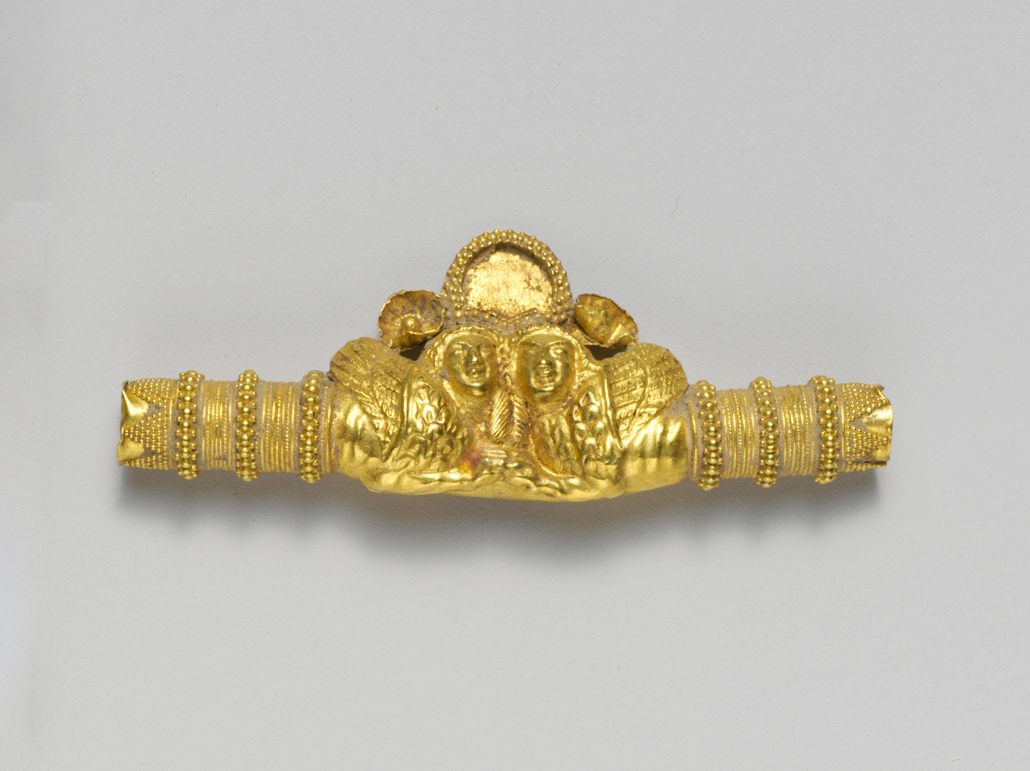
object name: bead, control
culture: etruscan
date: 600-501 BCE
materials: gold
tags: sphinx